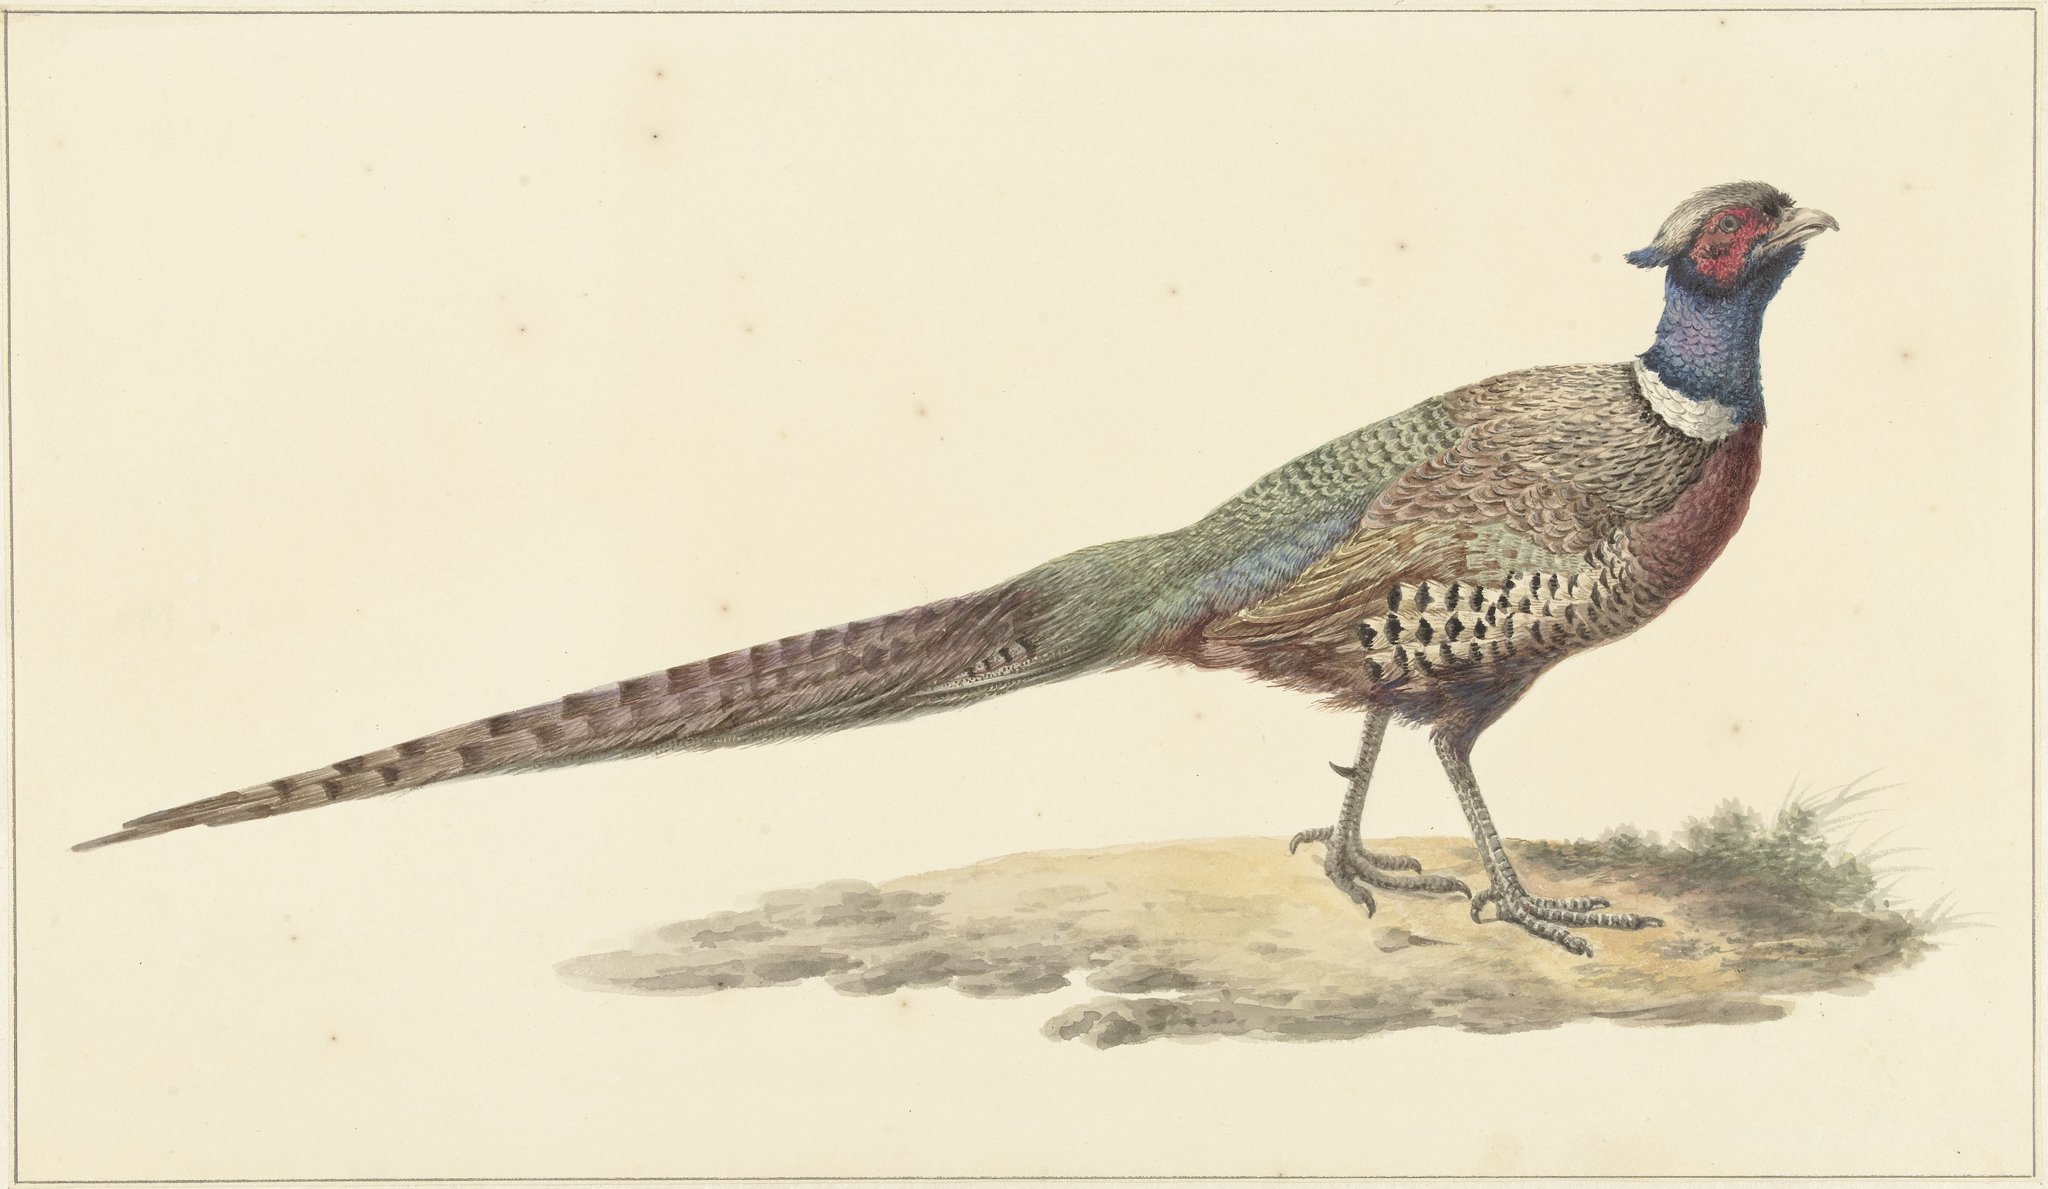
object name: watercolor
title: Fazant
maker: pieter pietersz. barbiers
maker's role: draughtsman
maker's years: 1749-1842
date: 1759-1842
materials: paper, pencil, watercolor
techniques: brush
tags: walker and runner birds: pheasant